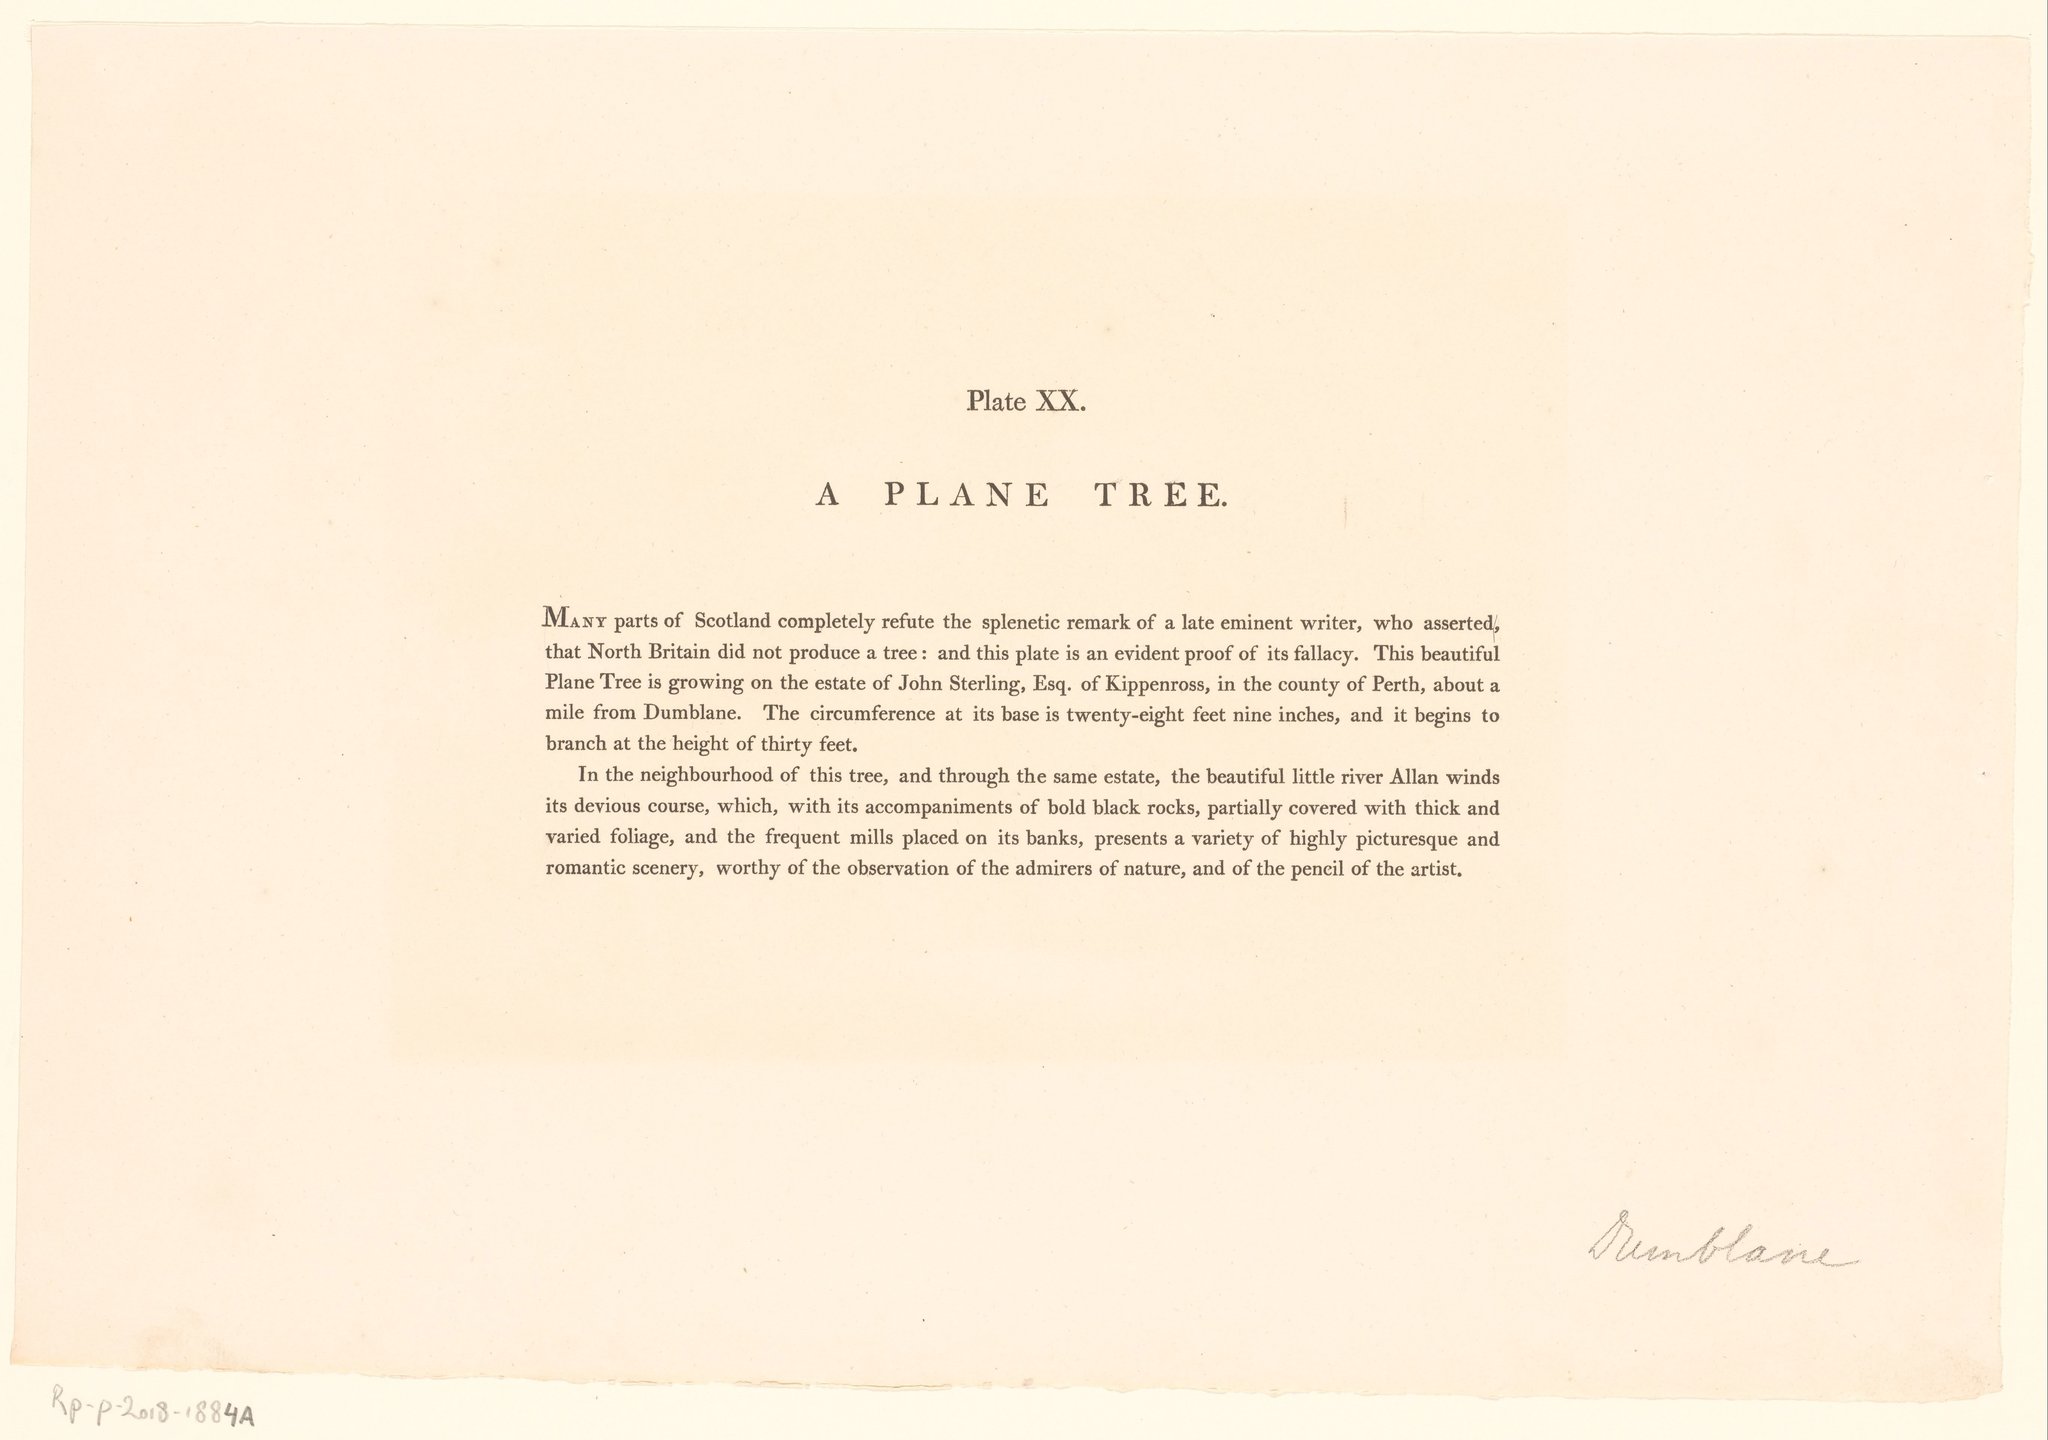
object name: text sheet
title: Tekstblad bij een prent van een plataan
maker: william miller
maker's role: bookseller, printer, publisher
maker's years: 1769-1844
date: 1801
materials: paper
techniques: letterpress printing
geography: london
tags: dunblane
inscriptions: collector's mark: Lugt 2228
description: Tekstblad gebruikt in: Scotia Depicta; or the antiquities, castles, public buildings, noblemen (...). Londen: William Miller, 1801.